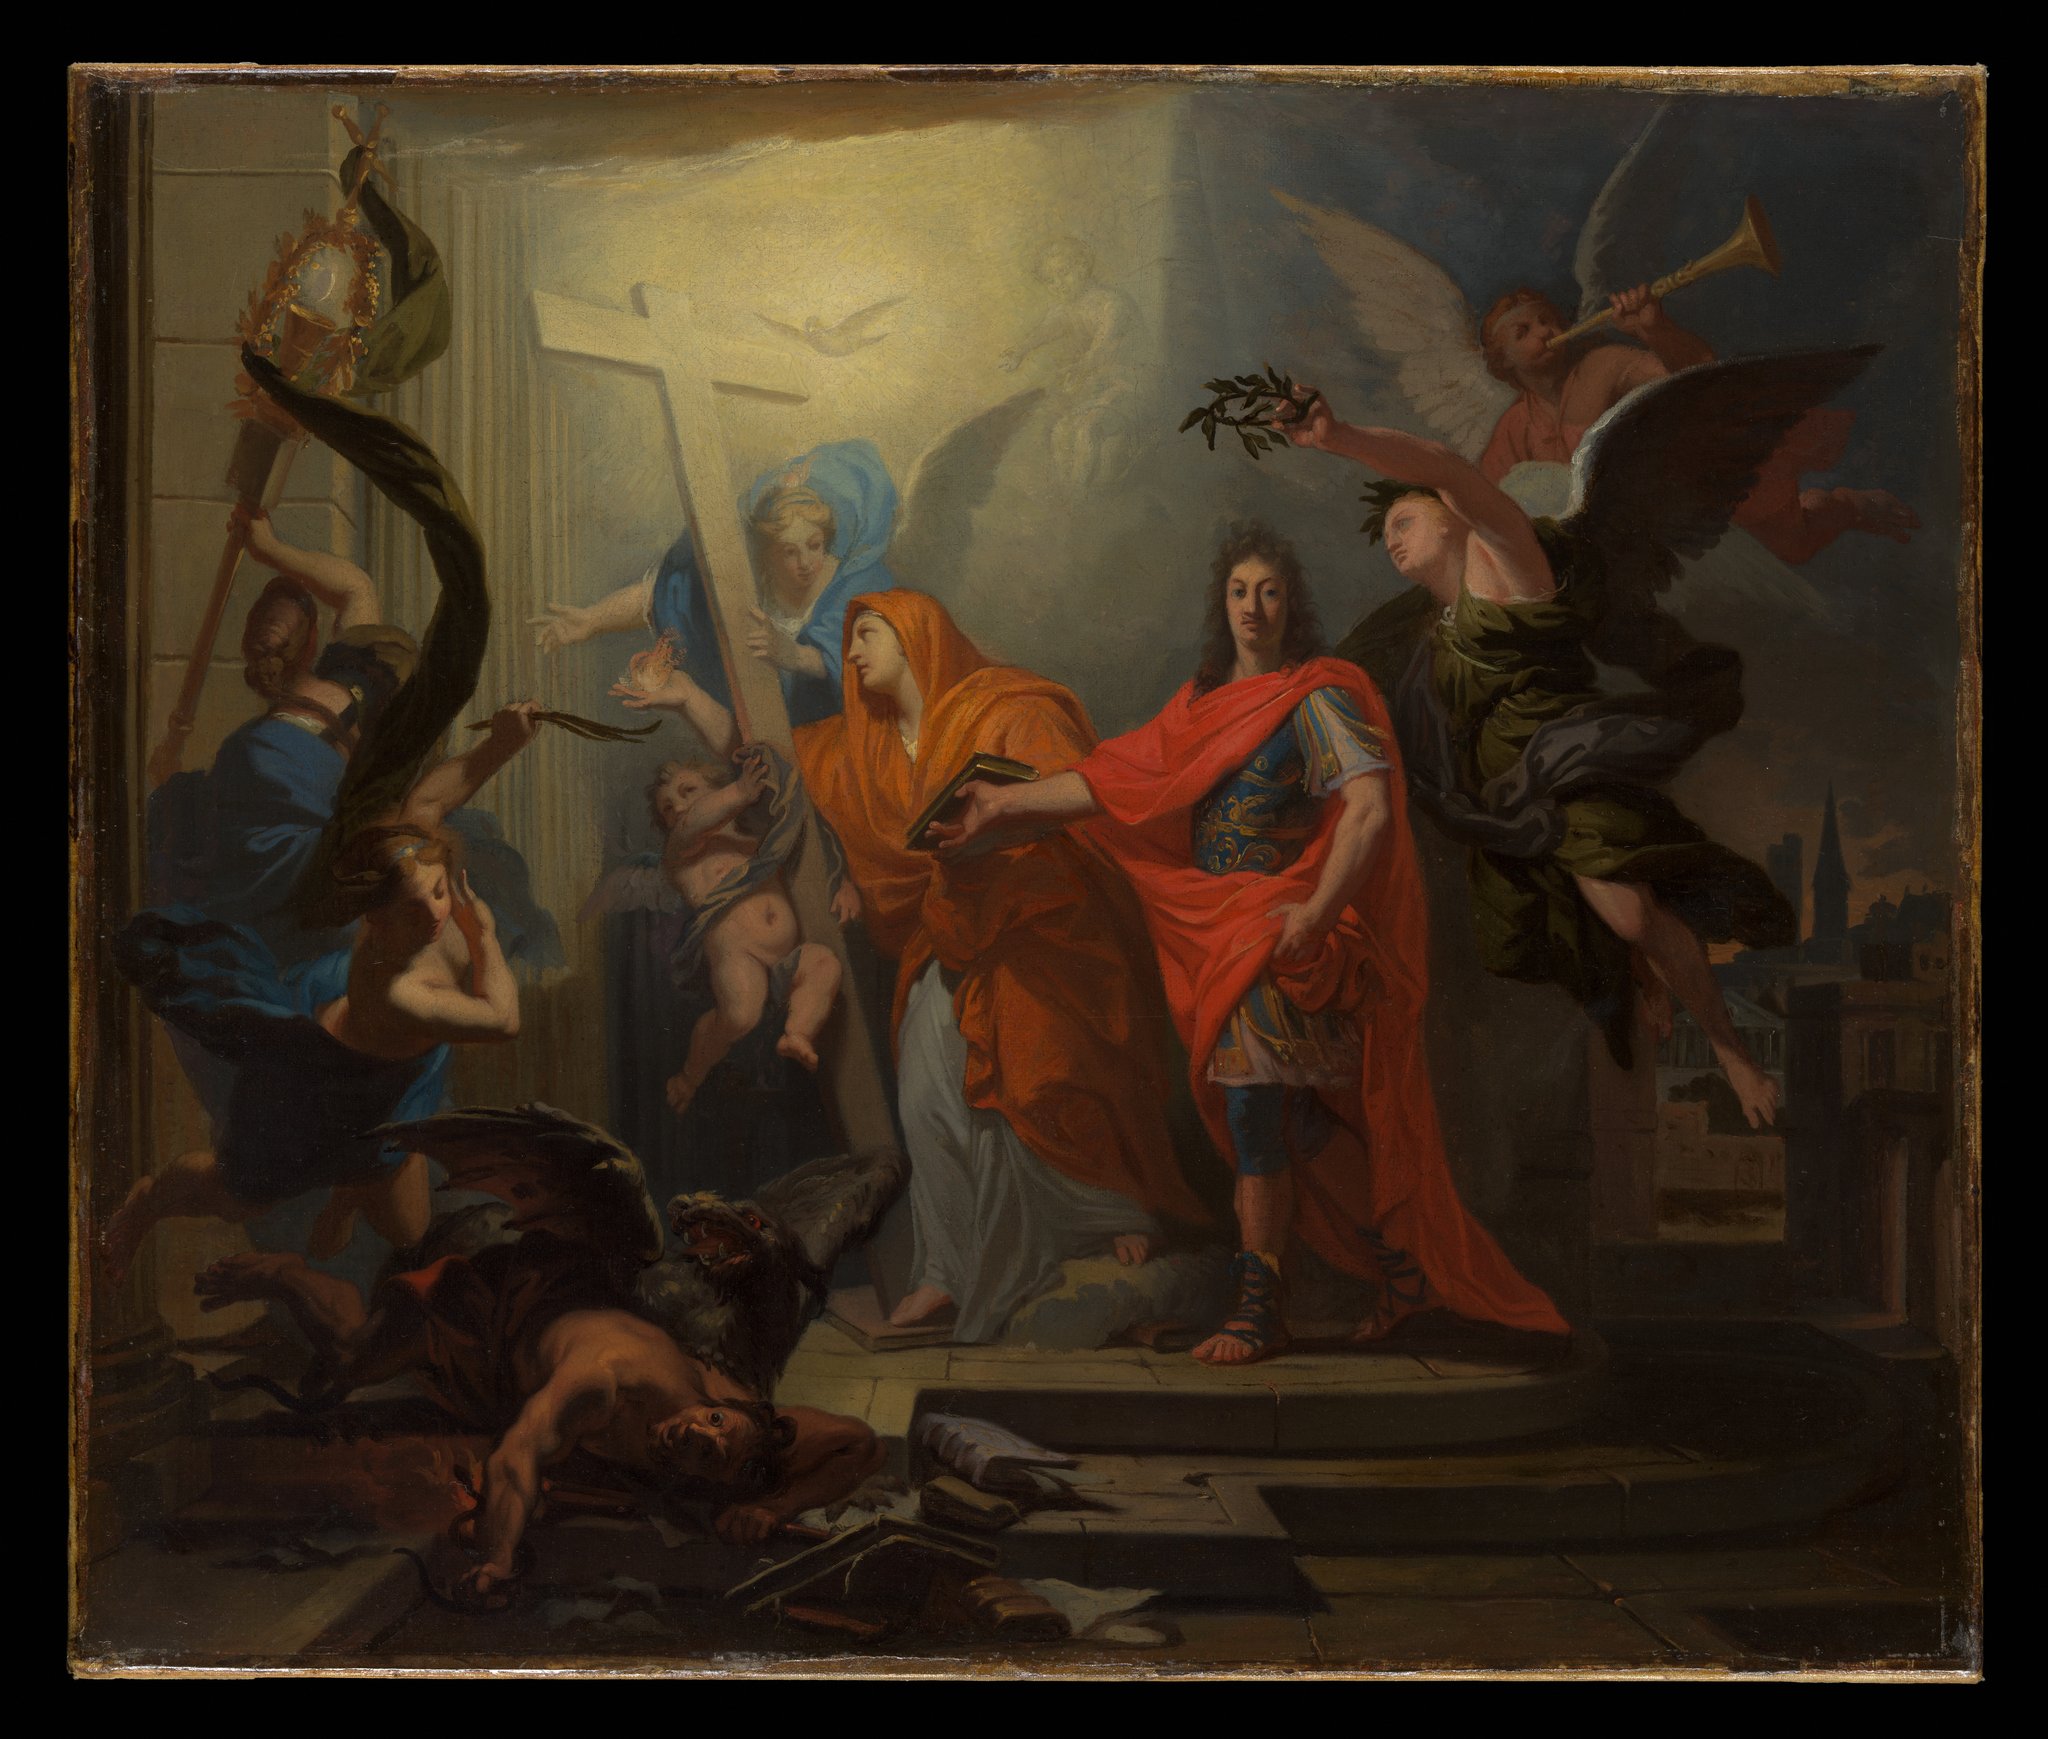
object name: painting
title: The Restoration of the Catholic Religion in Strasbourg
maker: claude guy hallé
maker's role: artist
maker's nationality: french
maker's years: 1652-1736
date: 1681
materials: canvas, oil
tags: men,women,angels,cross